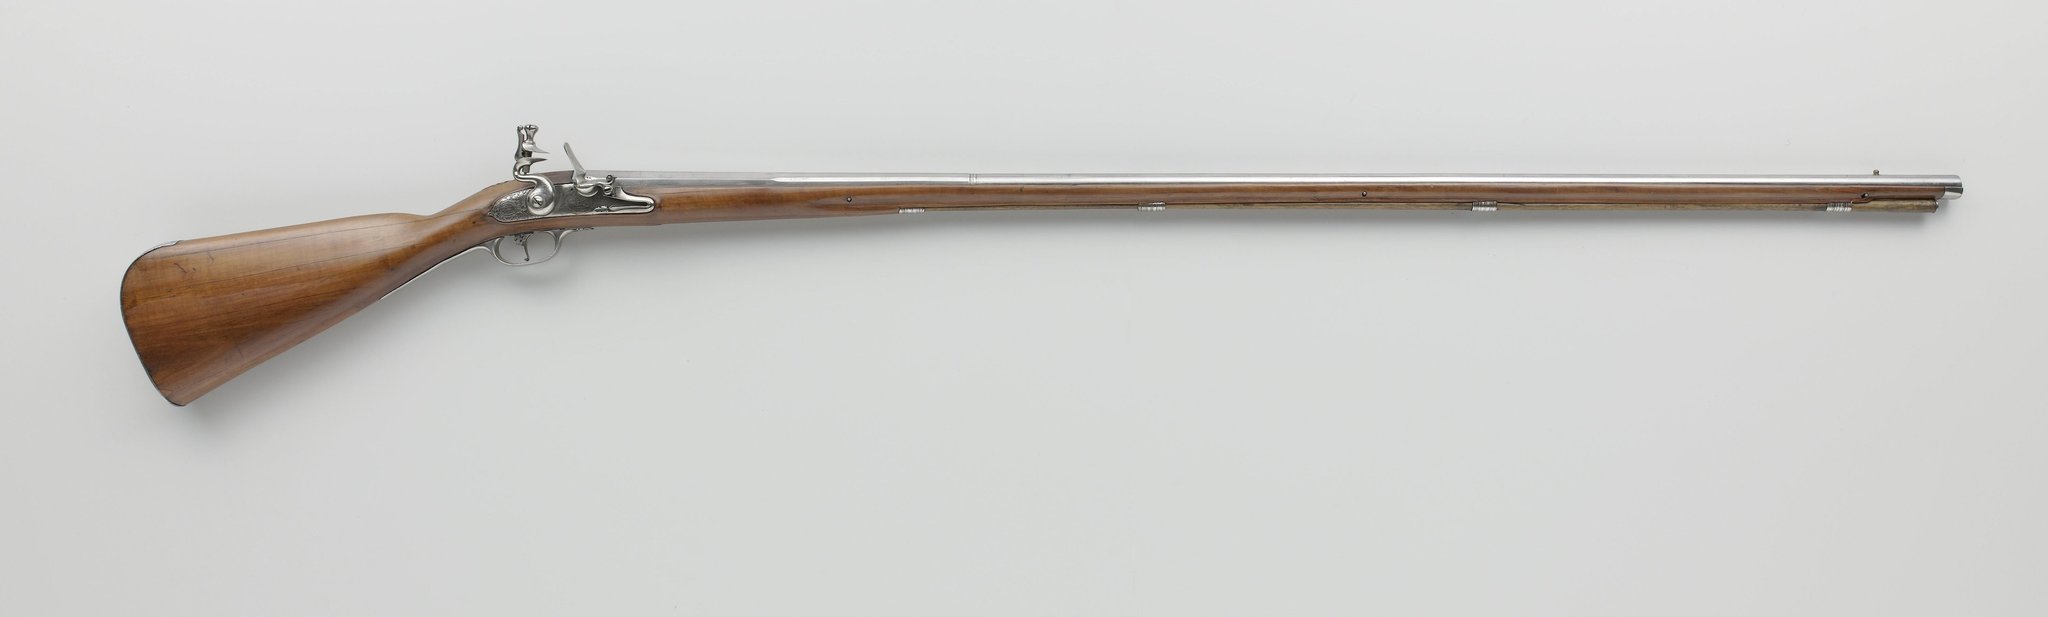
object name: flintlock pistol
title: Vuursteenjachtgeweer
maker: cornelis coster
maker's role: geweermaker, pistoolmaker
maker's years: -1698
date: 1660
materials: brass, iron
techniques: cutting, embroidery, engraving, gilding, striking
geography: utrecht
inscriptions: inscription: ‘CORNELIS // COSTER’, inscription: ‘VTRECHT’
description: De slotplaat is gegraveerd met menselijke figuren, bladerranken en een signatuur. De loop is voorzien van een vergulde, geelkoperen korrel. De kolf is eenvoudig gesneden met onder meer een blad. Het ijzeren beslag bestaat onder andere uit vier laadstokkokers, een ajour bewerkte en gegraveerde schroefplaat in de vorm van een heraldisch embleem van een schild gedragen door engelen en geblazoeneerd met een klein schild in het midden, en ajour bewerkt beitelwerk achter de trekker.